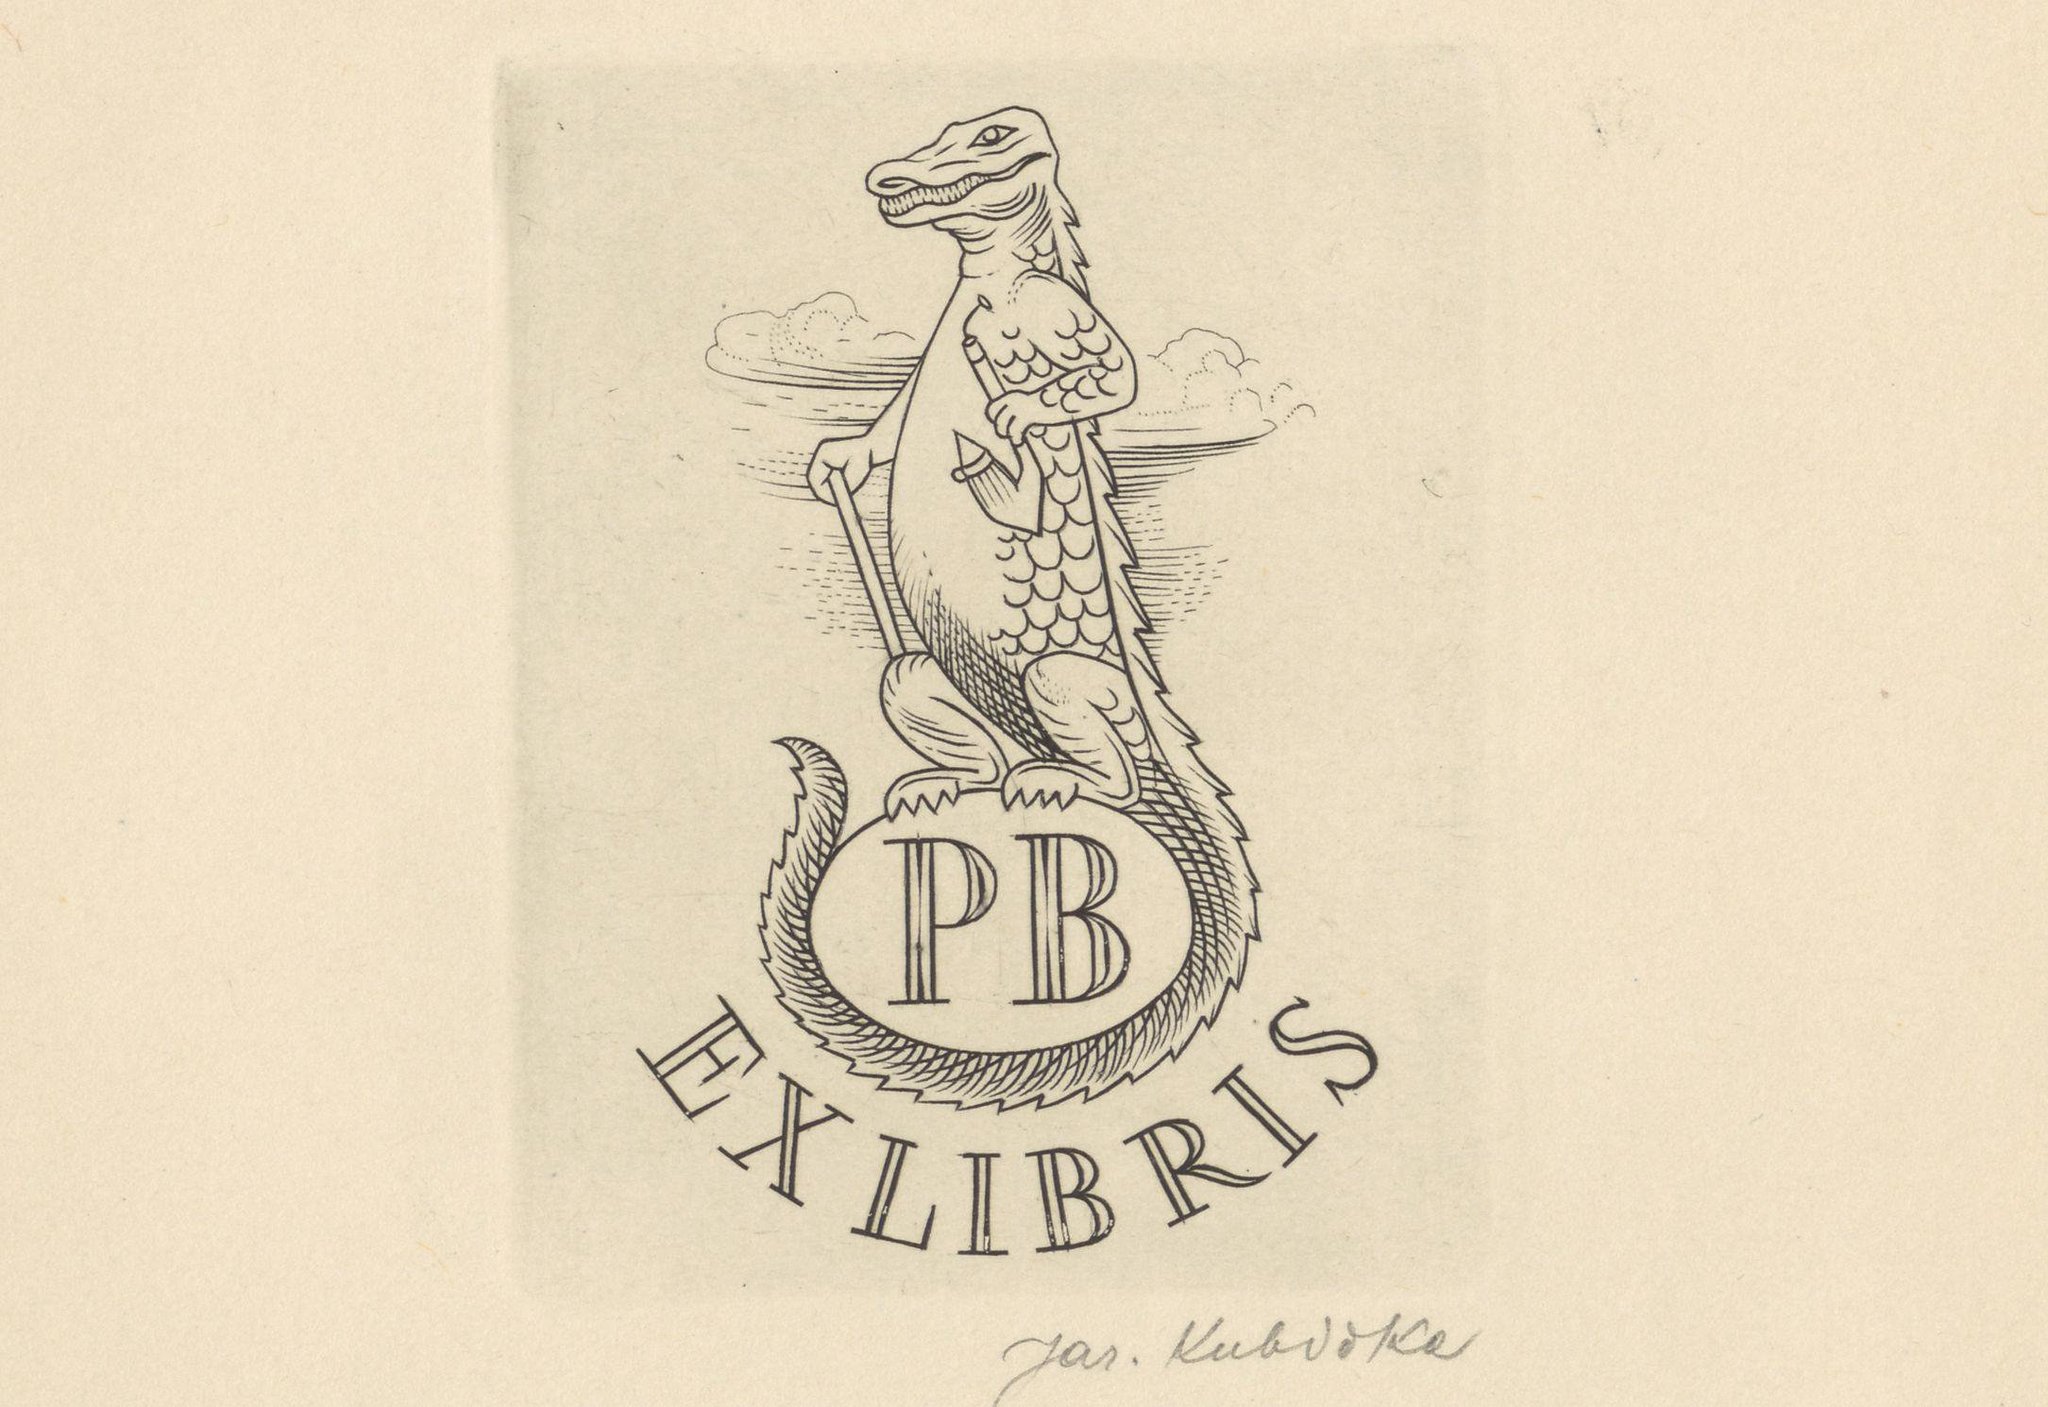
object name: bookplate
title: P.B. ex libris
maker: jar. kubicka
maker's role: print maker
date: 1900-1958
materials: paper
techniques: engraving, intaglio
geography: czech republic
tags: crocodiles, pipe ~ tobacco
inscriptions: signature: ‘Jar. Kubicka’